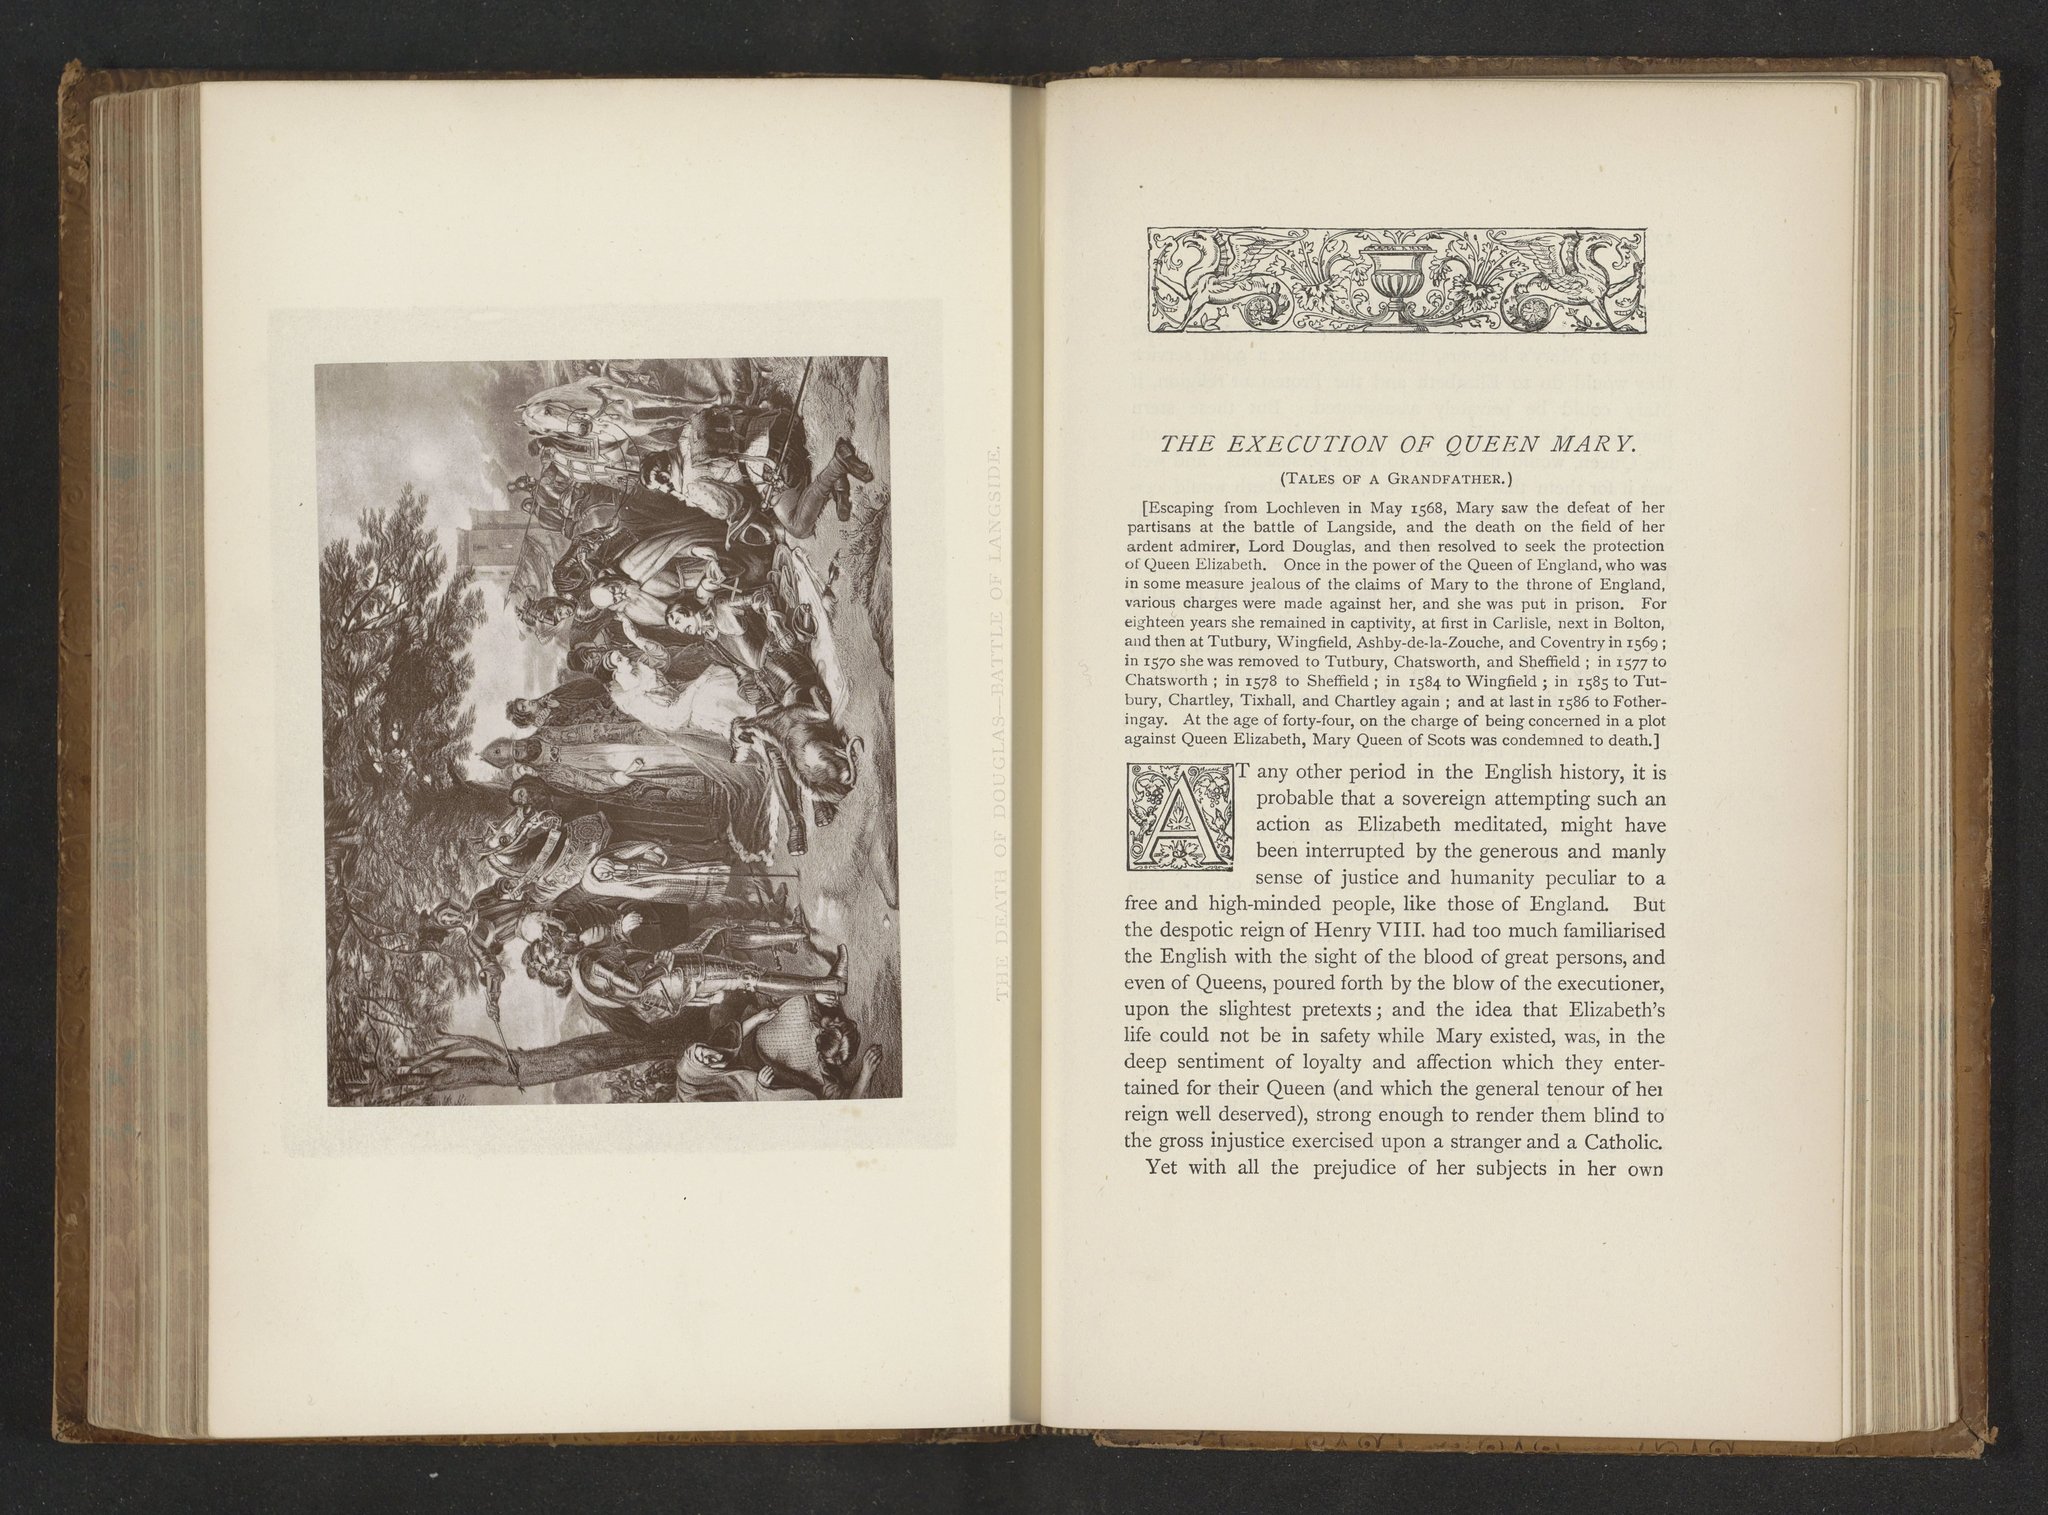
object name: photomechanical print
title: The death of Douglas-battle of Langside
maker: Anonymous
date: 1874-1884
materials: paper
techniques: woodburytype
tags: violent death by blows, kicks, pricks, etc. - ee - death not certain; wounded person, battle, ruler, sovereign - bb - female ruler